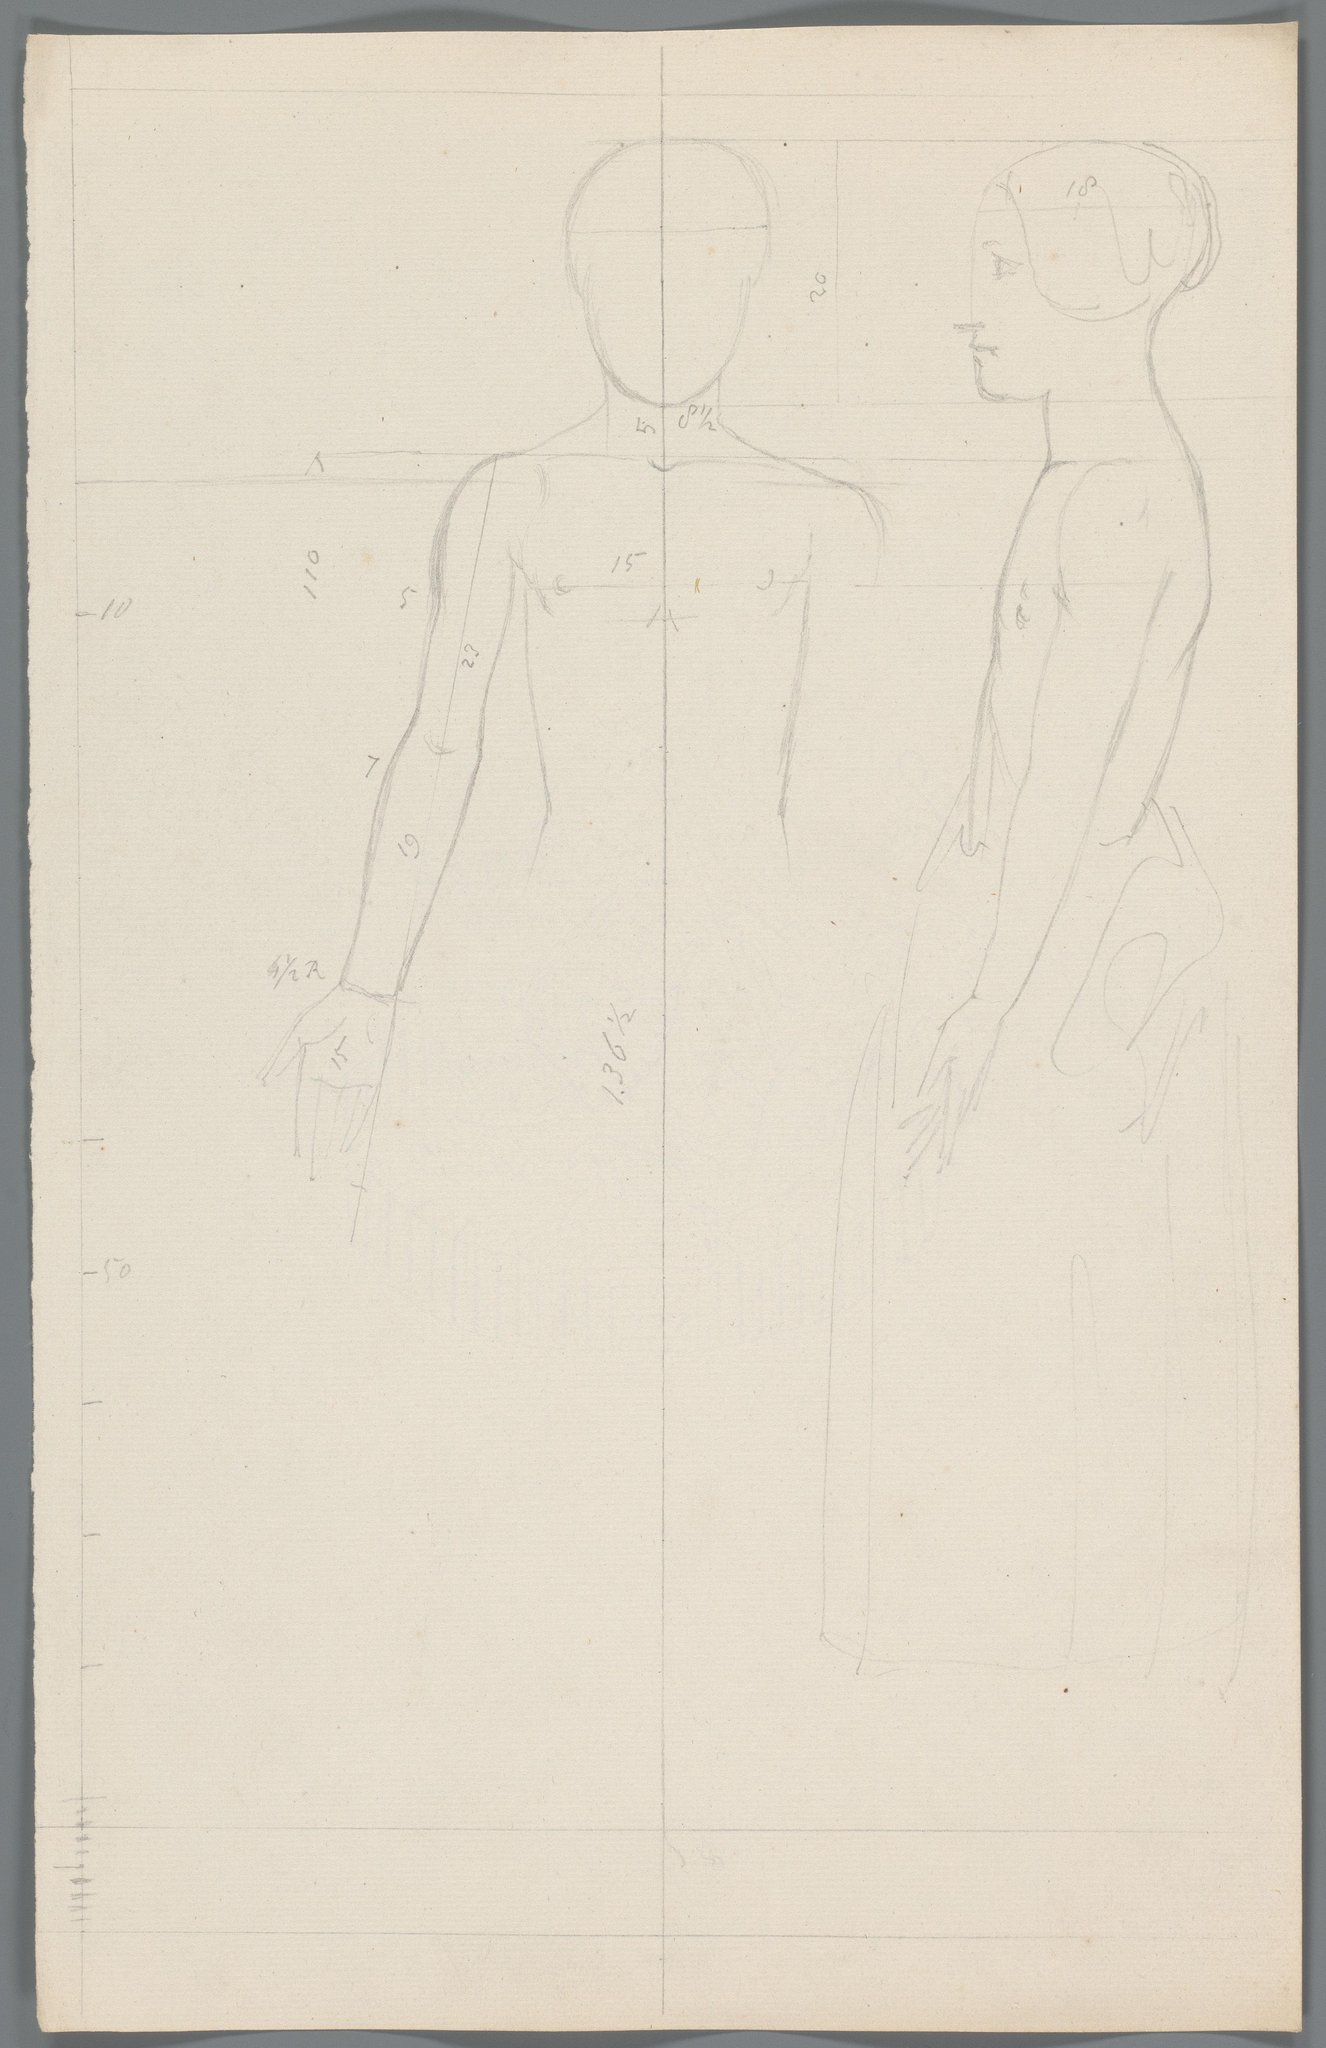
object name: drawing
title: Proportiestudie van een meisje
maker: jacobus everhardus josephus van den berg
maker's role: draughtsman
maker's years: 1802-1861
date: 1812-1861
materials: paper, pencil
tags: anatomy (non-medical), standing figure (canon, proportions) - aa - female human figure, child (at home) - aa - girl